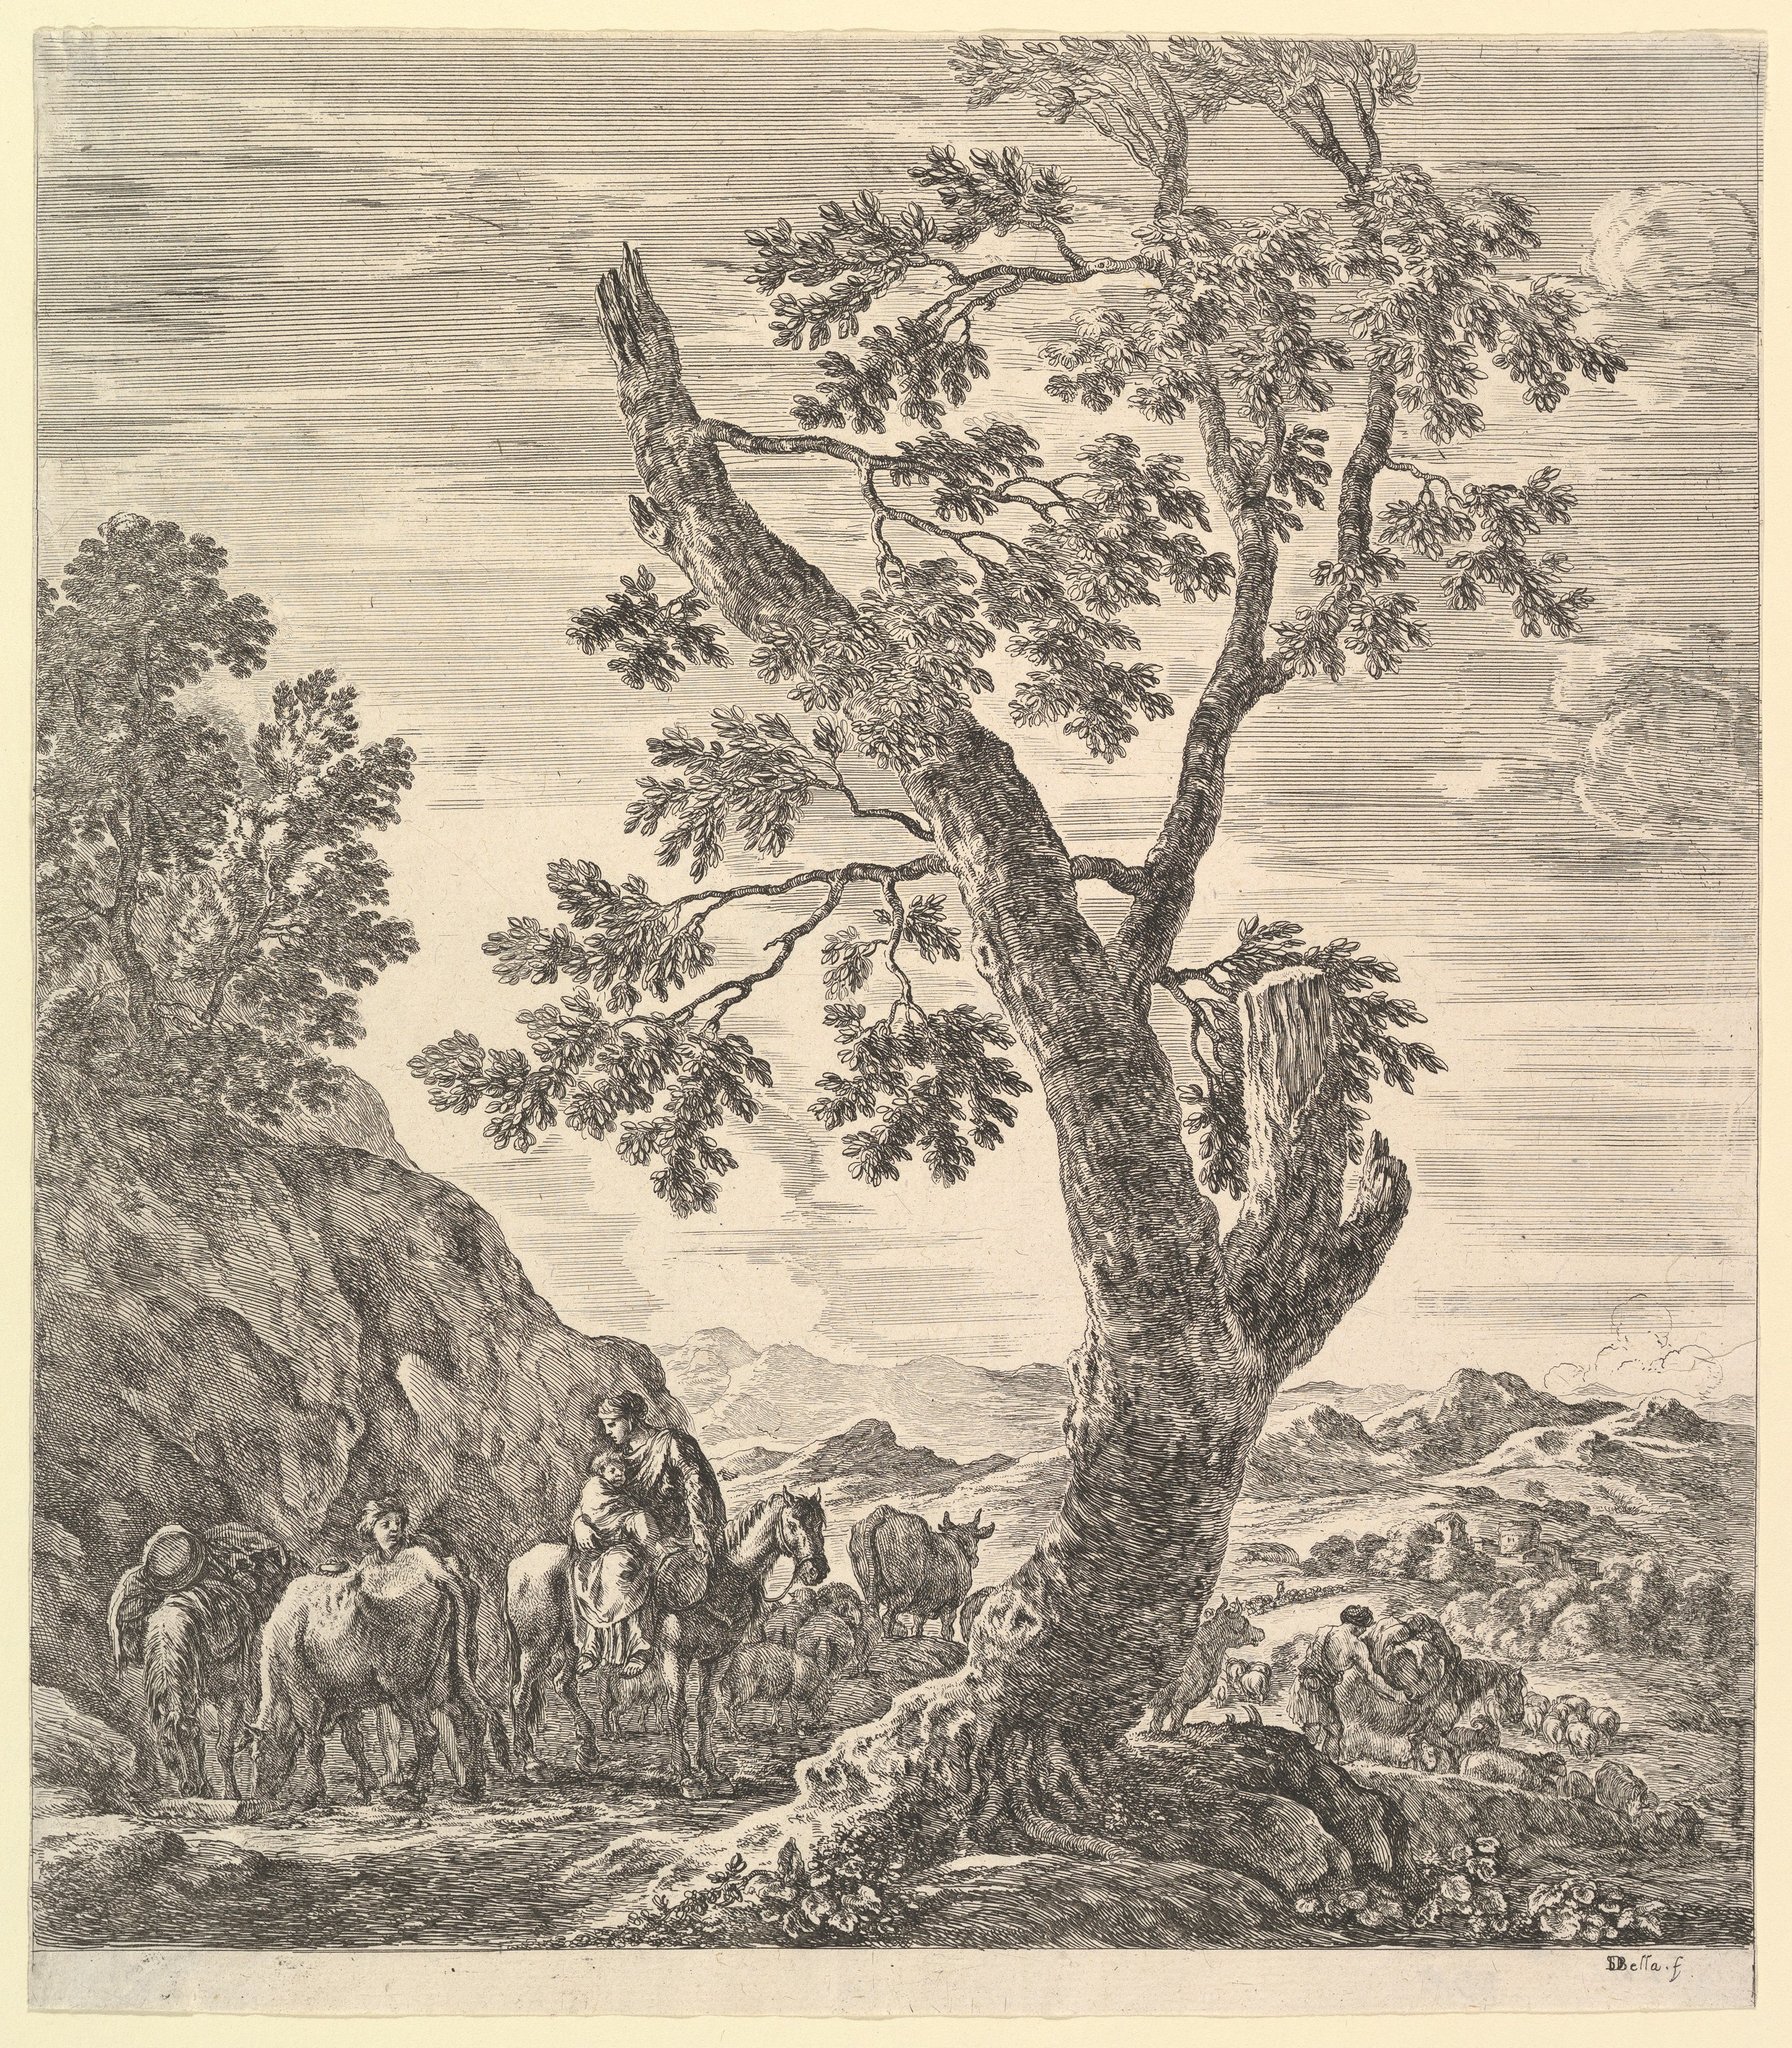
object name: print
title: A shepherd with two horses and a peasant woman on horseback with a child in her arms to left, a large tree in center, from "Six large views, four of Rome and two of the Roman countryside" (Six grandes vues, dont quatre de Rome et deux de la Campagne romaine)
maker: stefano della bella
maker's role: artist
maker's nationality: italian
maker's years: 1610-1664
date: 1656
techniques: etching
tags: horses,trees,shepherds